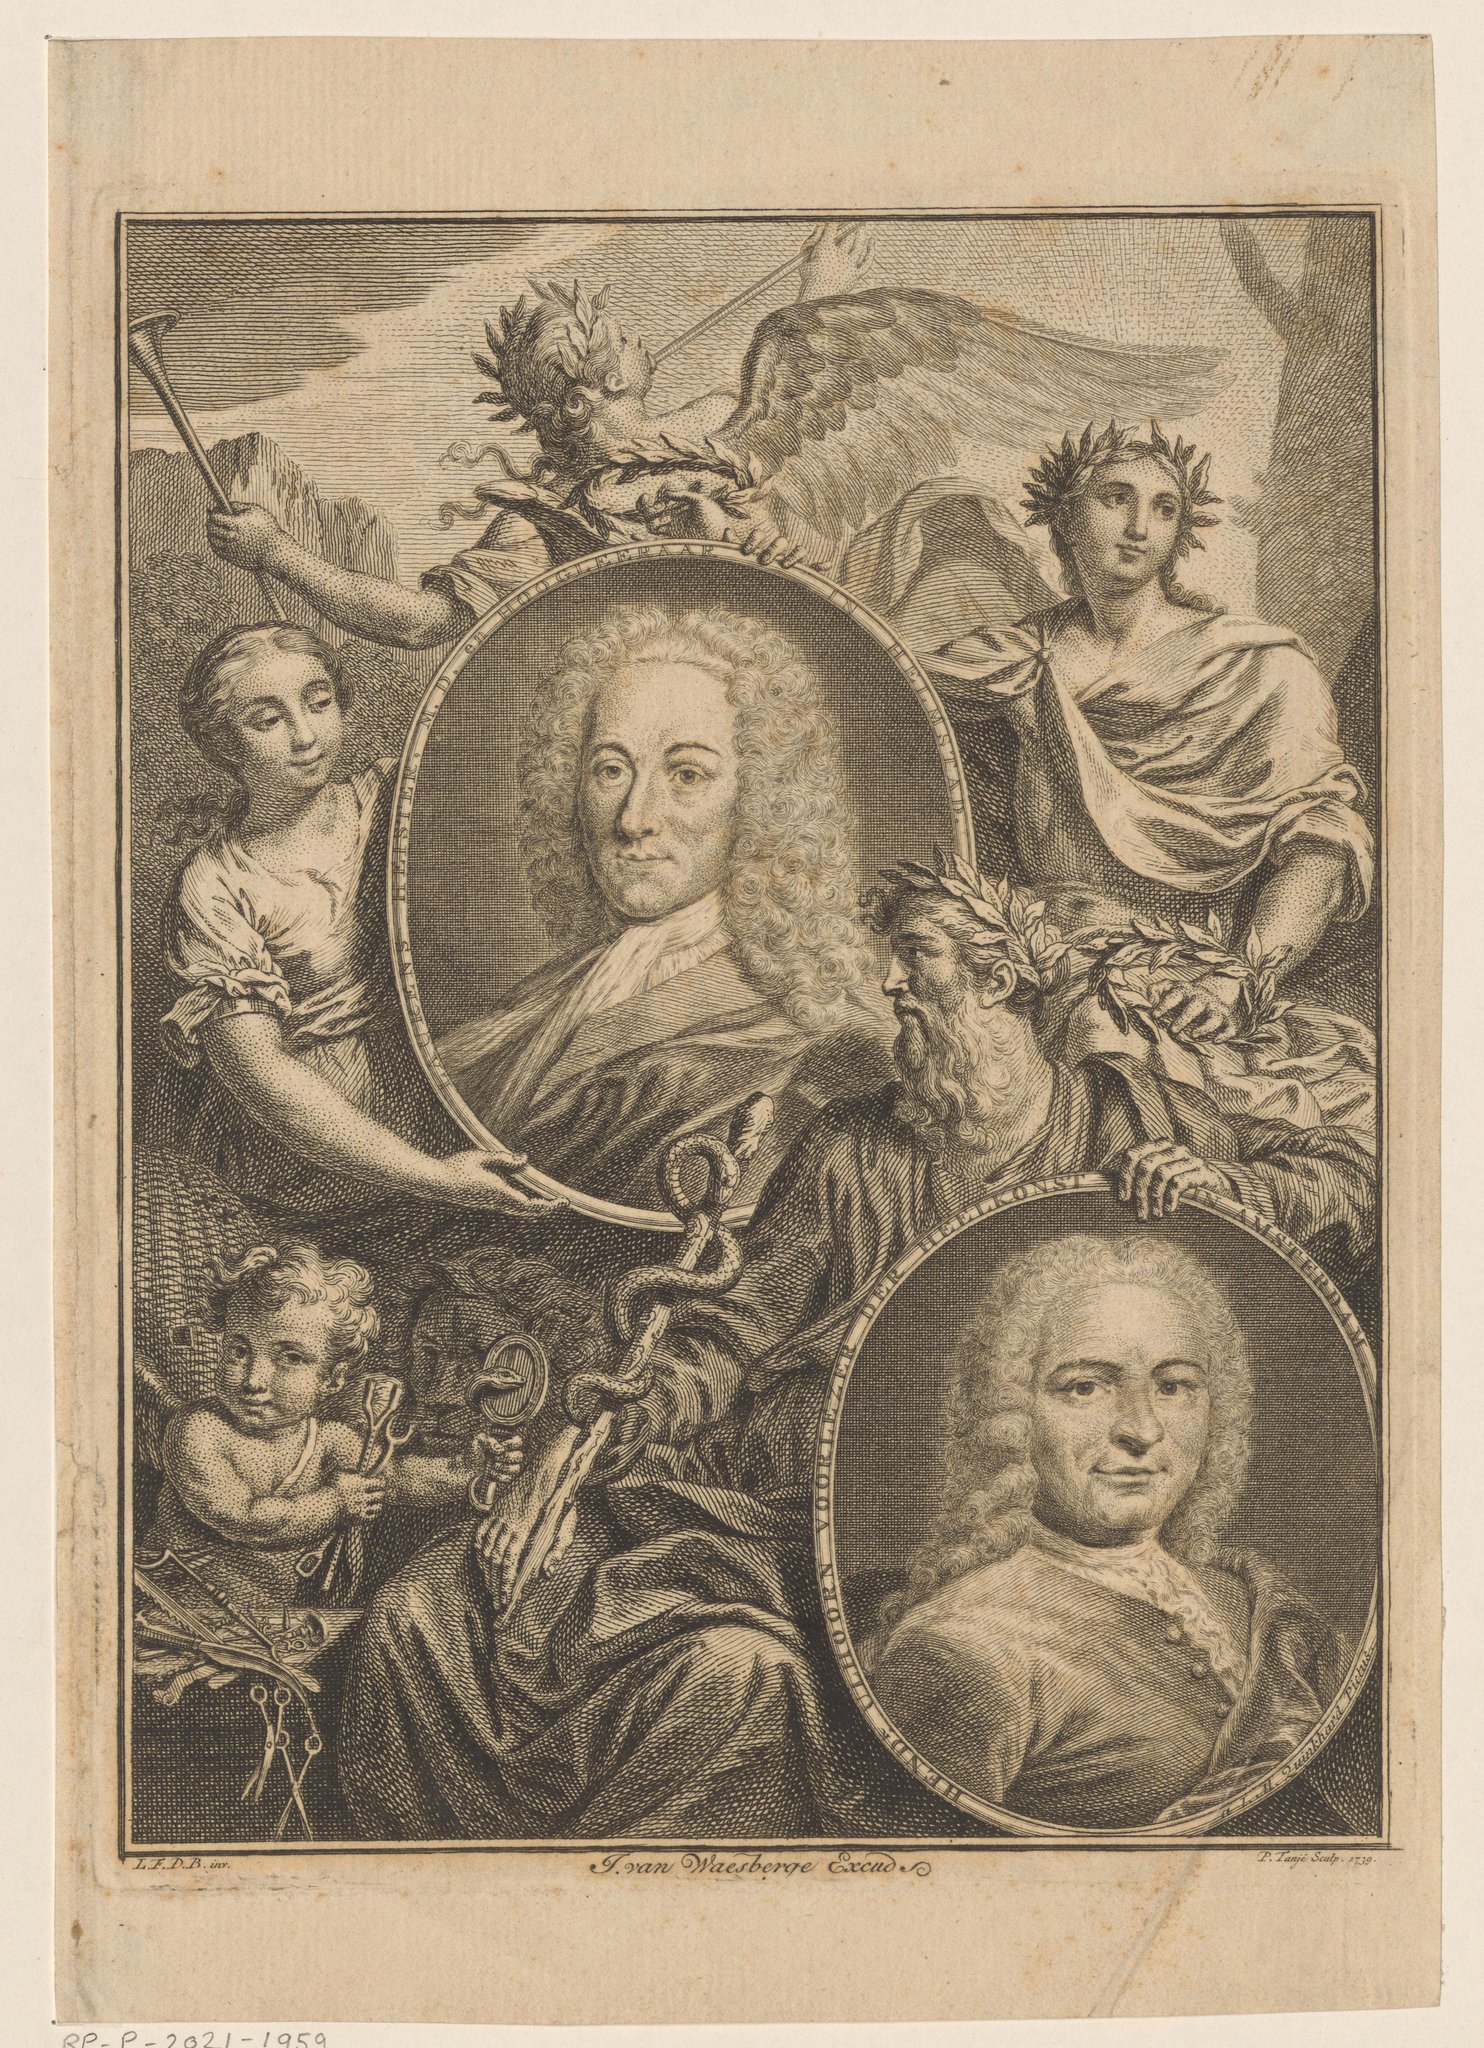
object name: print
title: Portretten van Lorenz Heister en Hendrik Ulhoorn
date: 1739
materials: paper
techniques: engraving, etching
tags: leiden, amsterdam, operation, surgery (+ variant), prudence, 'prudentia'; 'prudenza' (ripa) ~ one of the four cardinal virtues, historical persons, aesculapian sign, fame; 'fama', 'fama buona', 'fama chiara' (ripa)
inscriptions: date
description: Allegorische figuren met lauwerkransen op het hoofd tonen de portretten van Duits chirurg en hoogleraar Lorenz Heister en de Amsterdamse chirurg Hendrik Ulhoorn. Ulhoorn vertaalde en bewerkte Heisters boek 'Heelkundige onderwyzingen' uit het Duits. Bovenaan blaast Faam op de loftrompet. Aesculapius, de god van de gezondheid en geneeskunst houdt een esculaap in de ene hand en toont met de andere het portret van Ulhoorn. Links een putto met chirurgische instrumenten en een spiegel met slang, als symbool van de Voorzichtigheid.